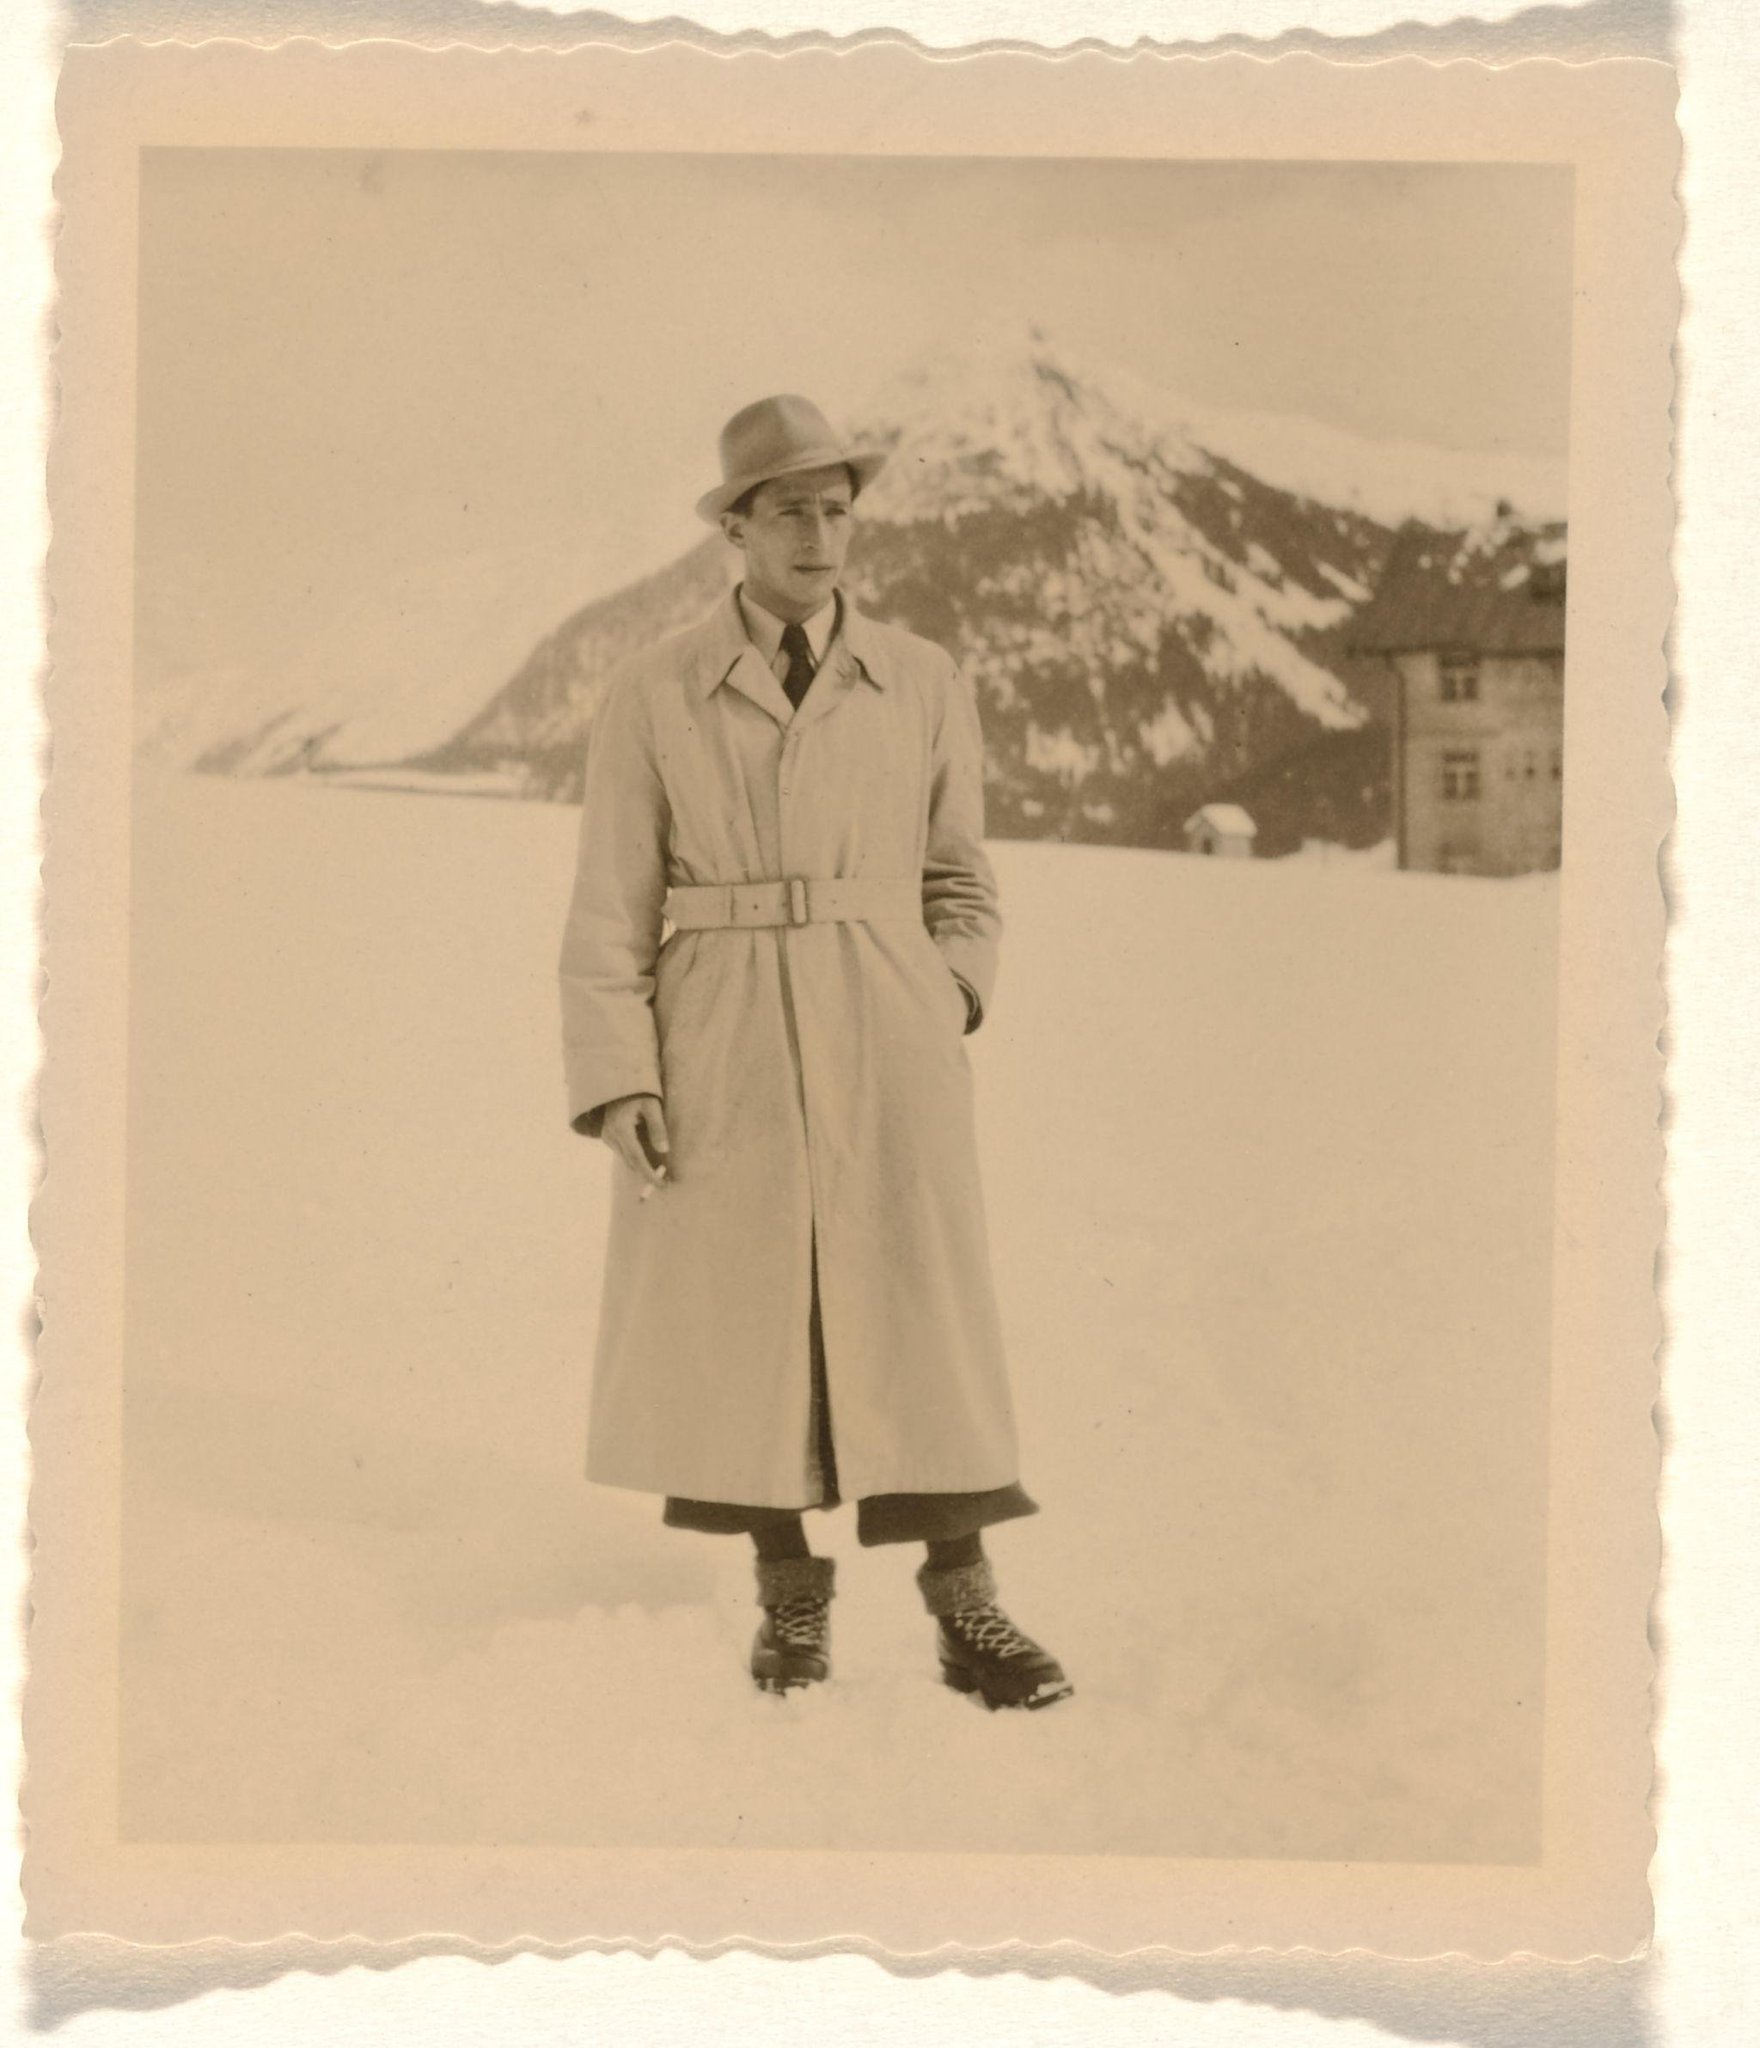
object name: photograph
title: Leo Blumensohn met gleufhoed en lange jas in een besneeuwd berglandschap, 1945-1949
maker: Anonymous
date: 1945-1949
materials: photographic support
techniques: gelatin silver print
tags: isabel wachenheimer-elon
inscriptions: inscription: ‘mein Leo.’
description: Leo Blumensohn met gleufhoed en lange jas in een besneeuwd berglandschap.